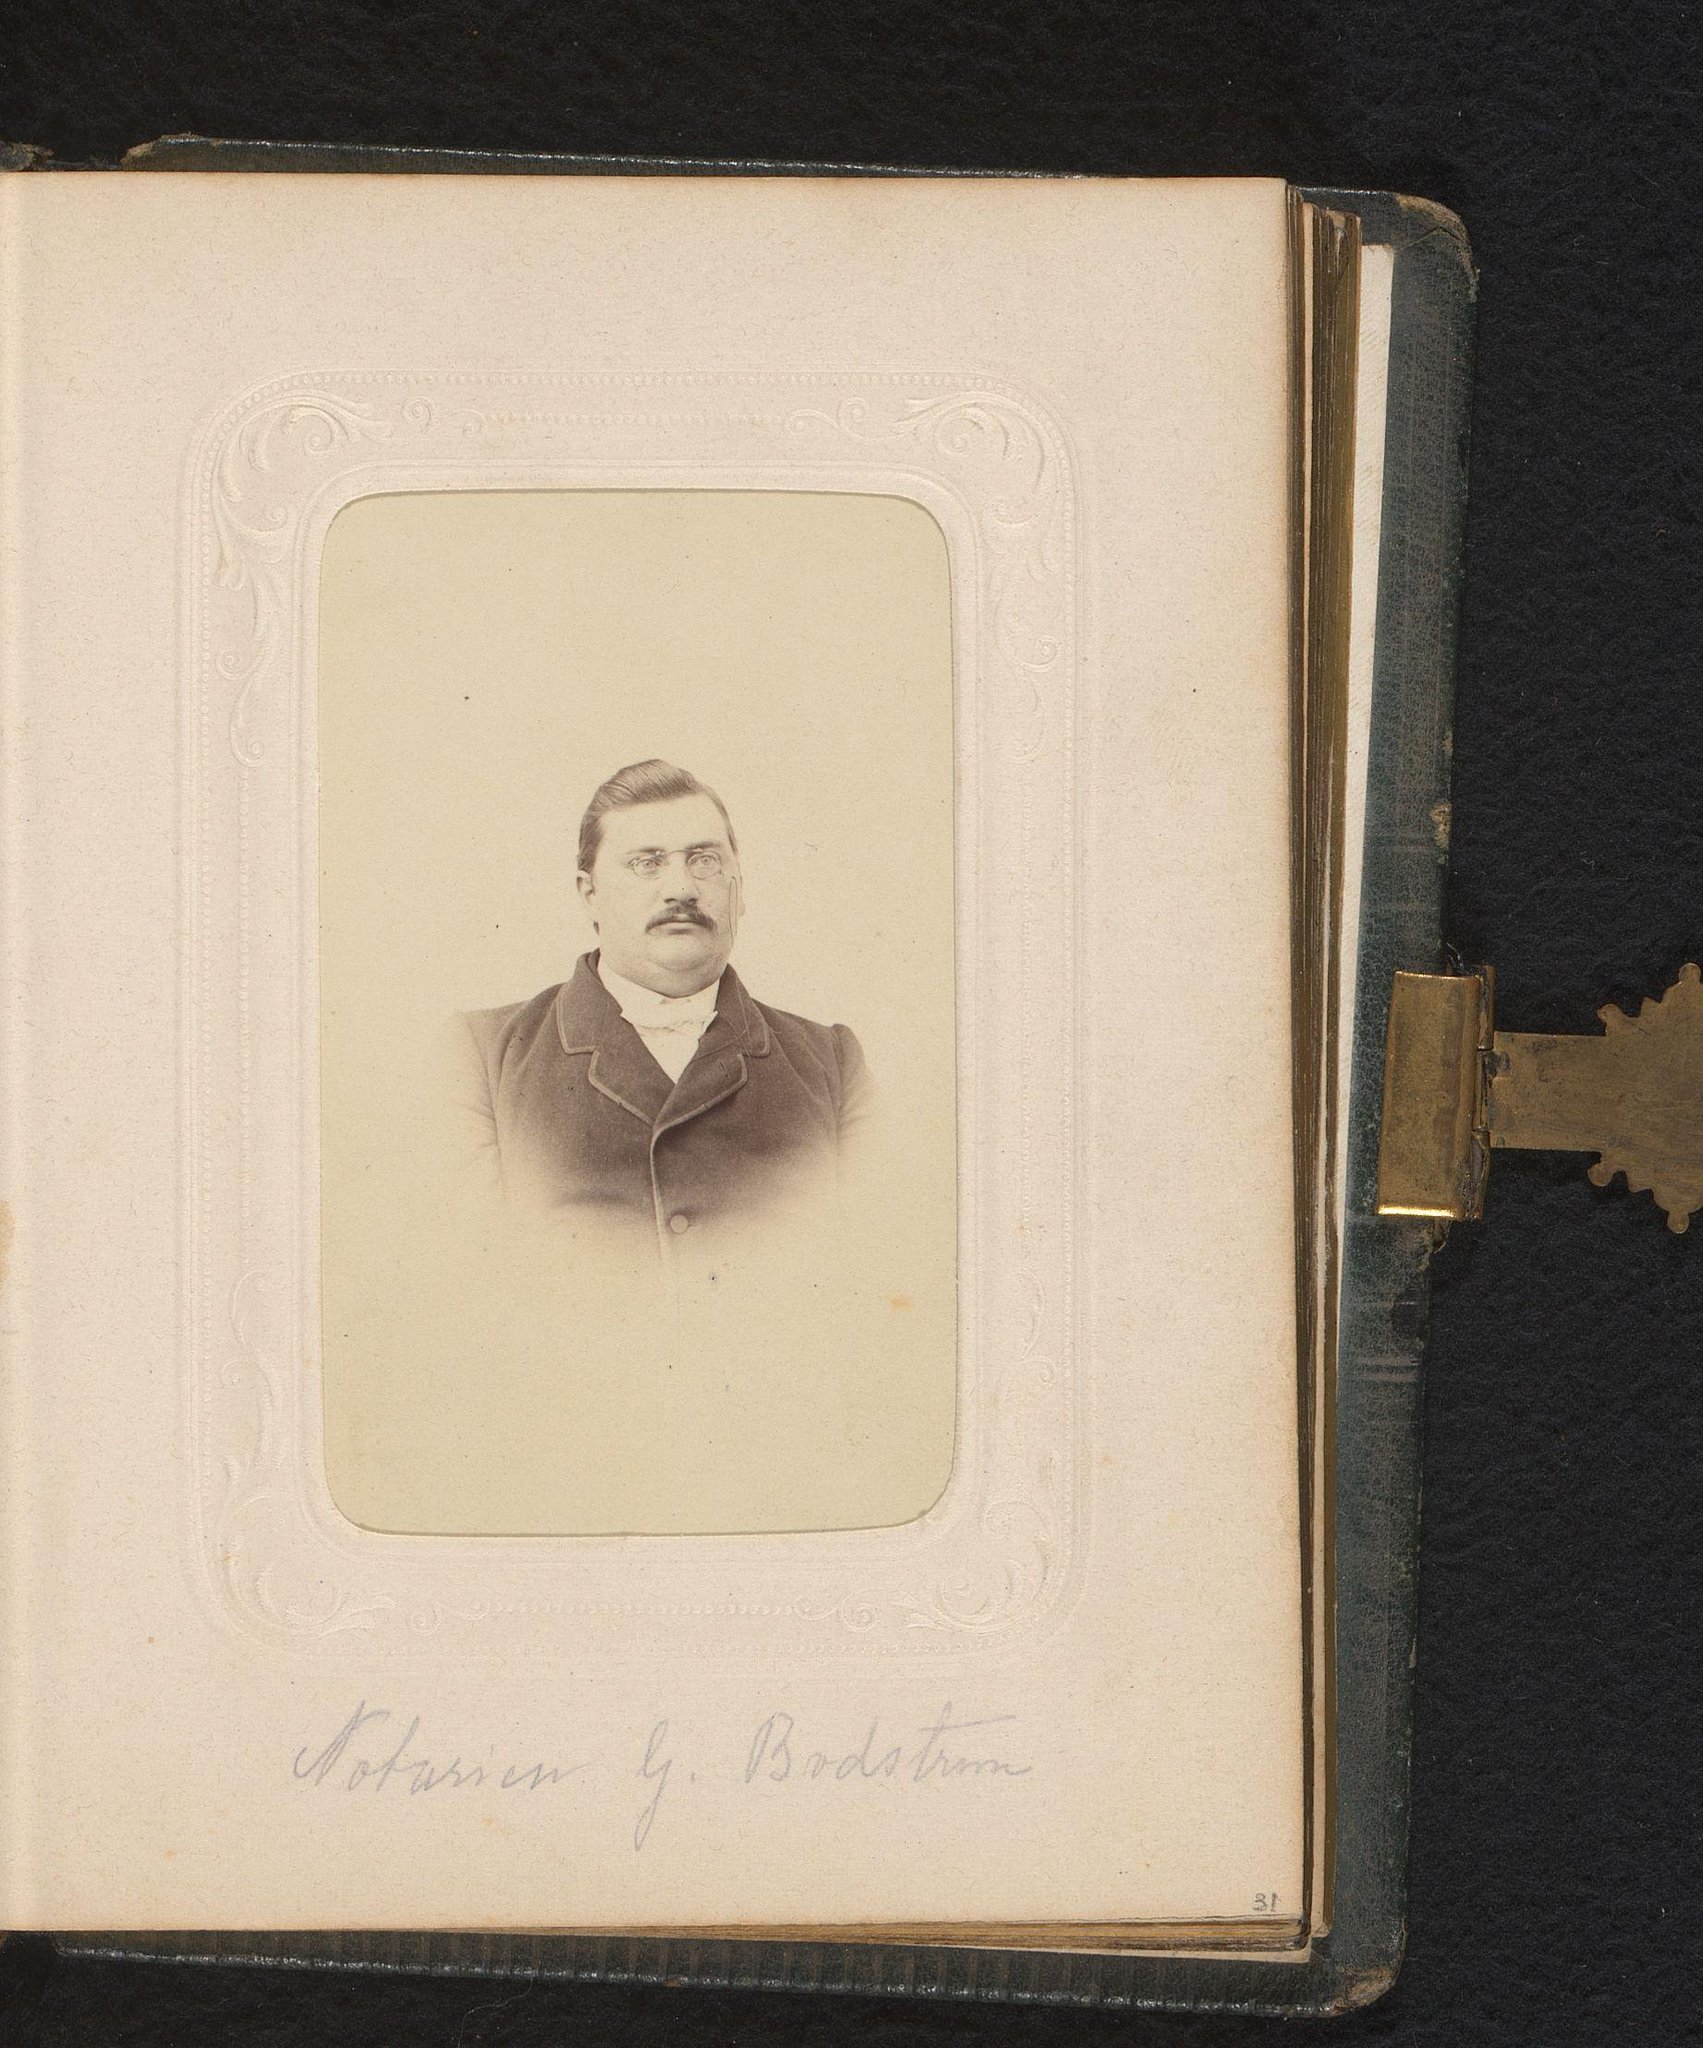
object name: photograph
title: Portret van een man met bril, aangeduid als Gustaf Bodström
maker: axel rydin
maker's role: fotograaf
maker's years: 1837-1912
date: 1860-1900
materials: cardboard, photographic support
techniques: albumen print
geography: sweden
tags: eyeglasses, spectacles, historical persons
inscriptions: annotation: ‘Natarien Gustaf Bodström/ Westerås’, name: ‘Natarien G. Bodstrom’, inscription: ‘Fotografi/ af/ Axel Rydin/ WESTERÅS’